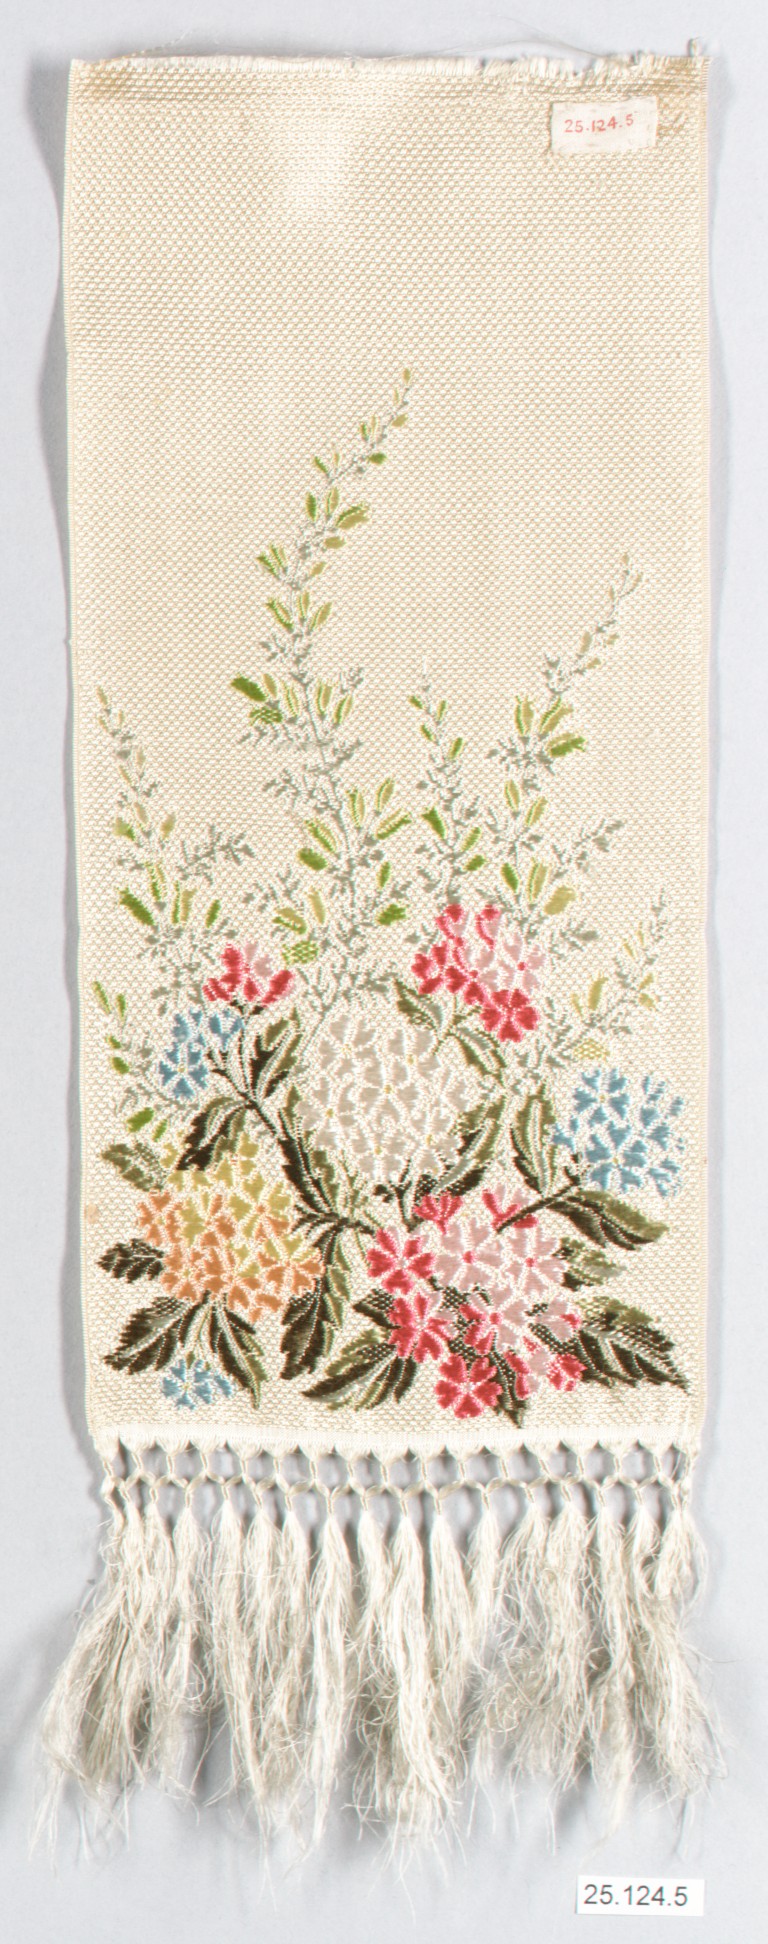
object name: necktie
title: Woman's necktie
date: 1870-1880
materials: silk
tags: flowers